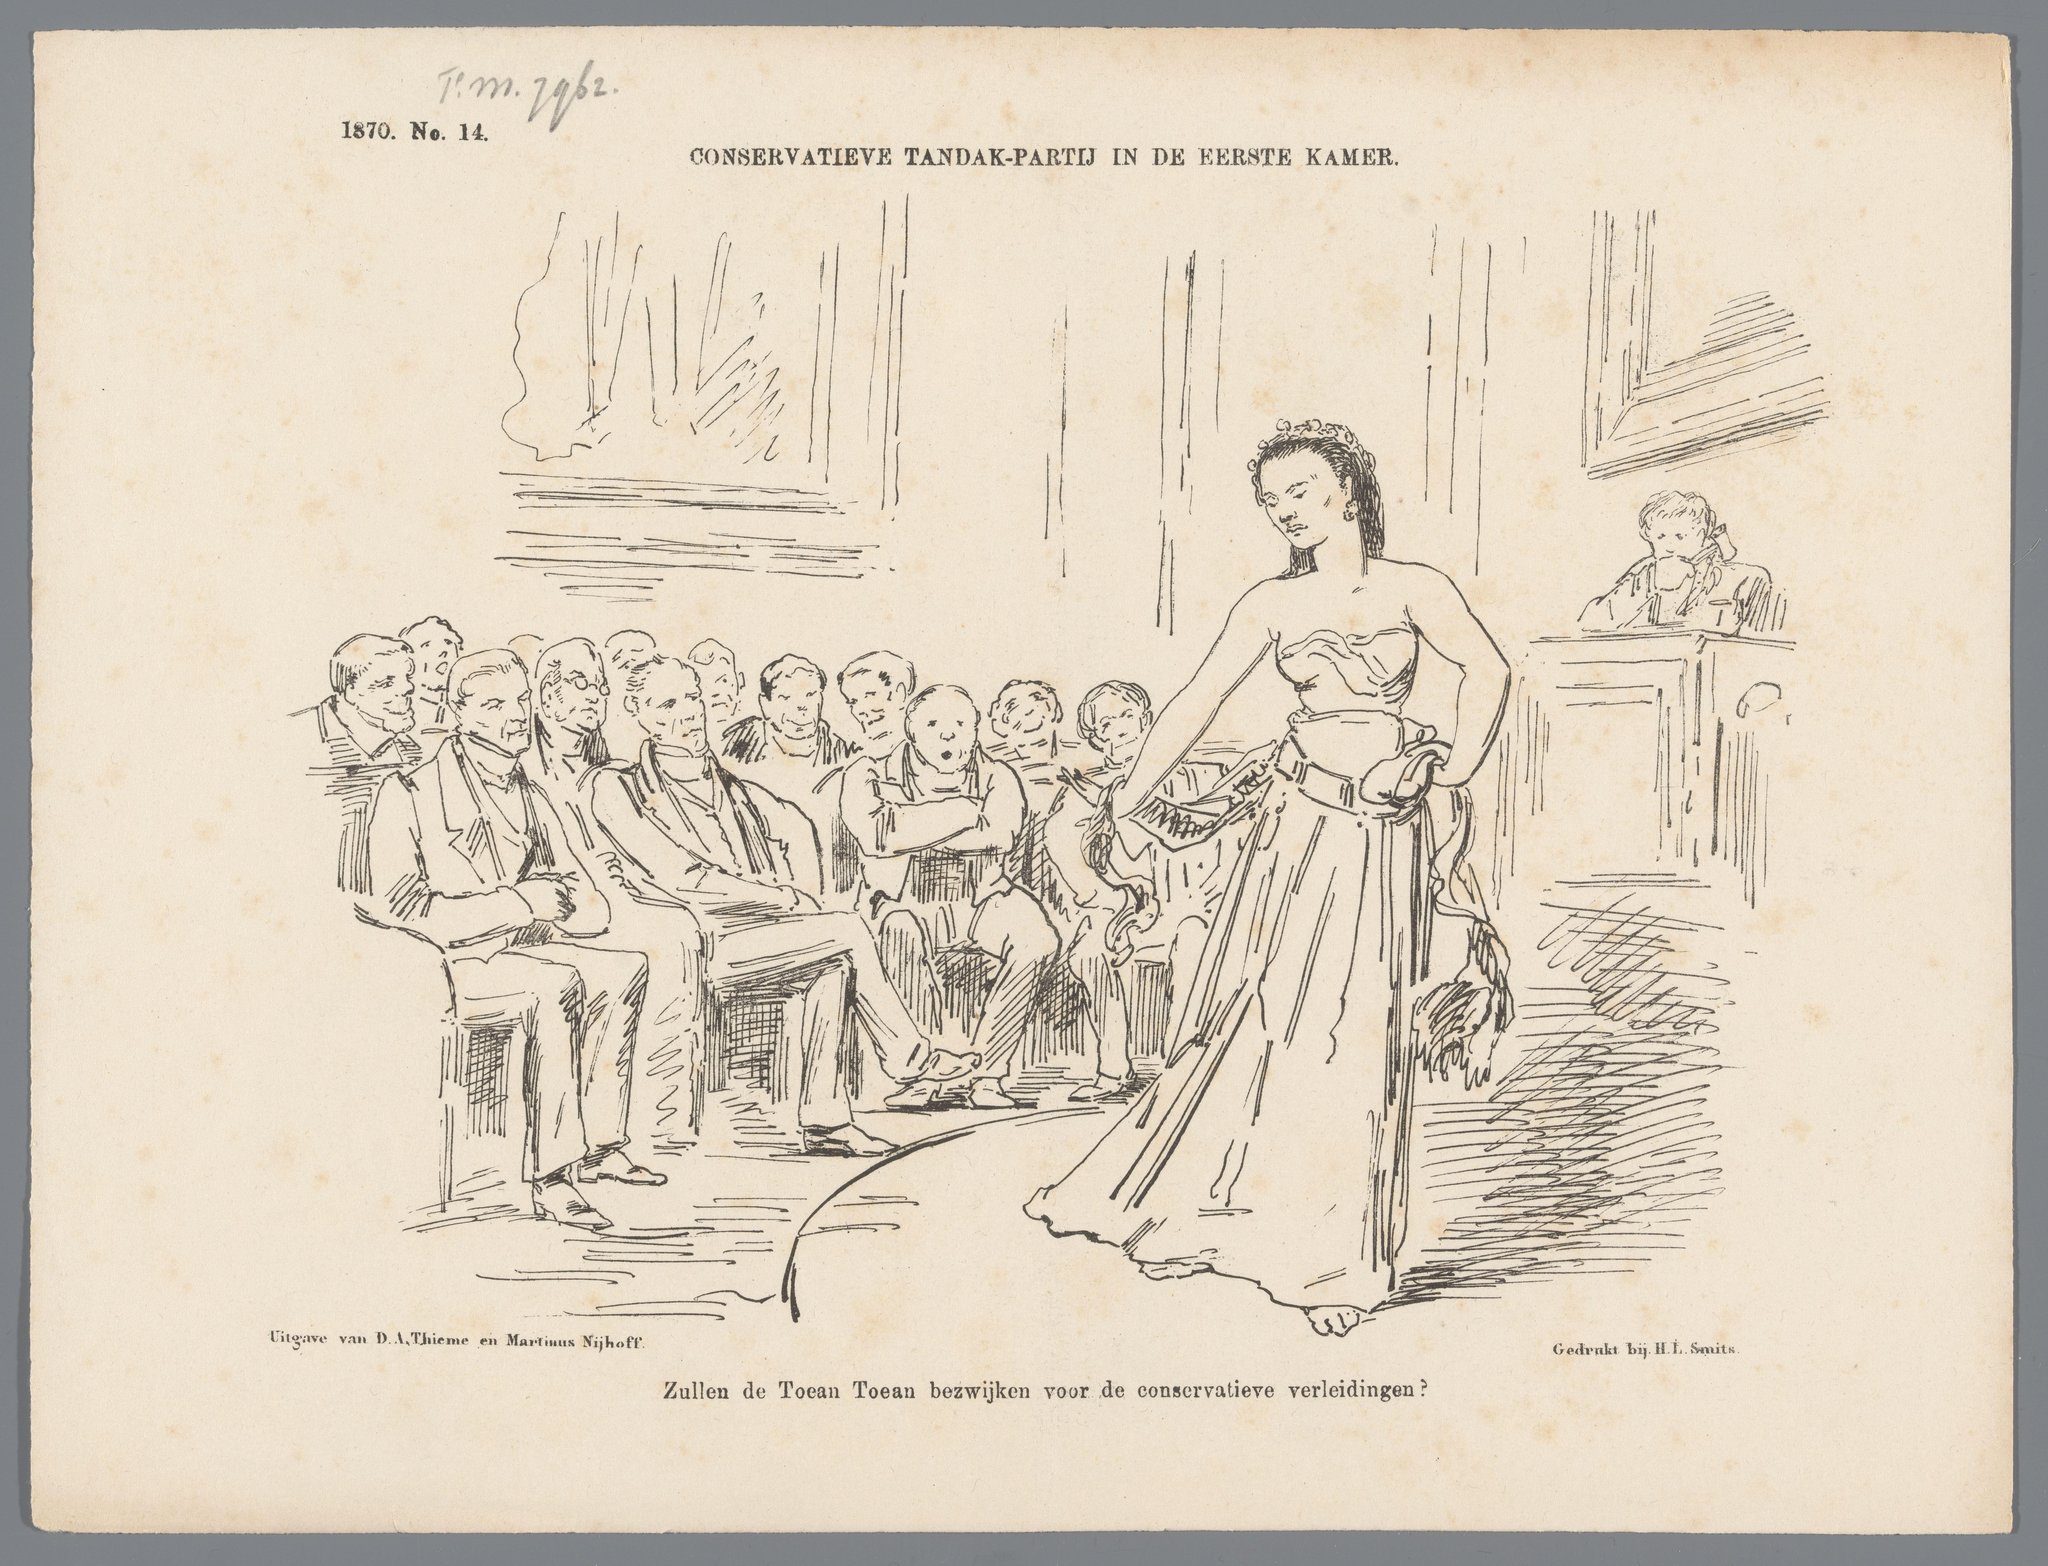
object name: cartoon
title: Conservatieve Tandak-partij in de Eerste Kamer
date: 1870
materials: paper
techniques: lithograph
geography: netherlands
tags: woman dancing alone, java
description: Spotprent over de behandeling van de Agrarische wet in de Eerste Kamer. Een Javaanse vrouw (de conservatieve partij) danst voor de leden van de Eerste Kamer. Plaat verschenen bij het weekblad De Nederlandsche Spectator, nr. 14, 1870.